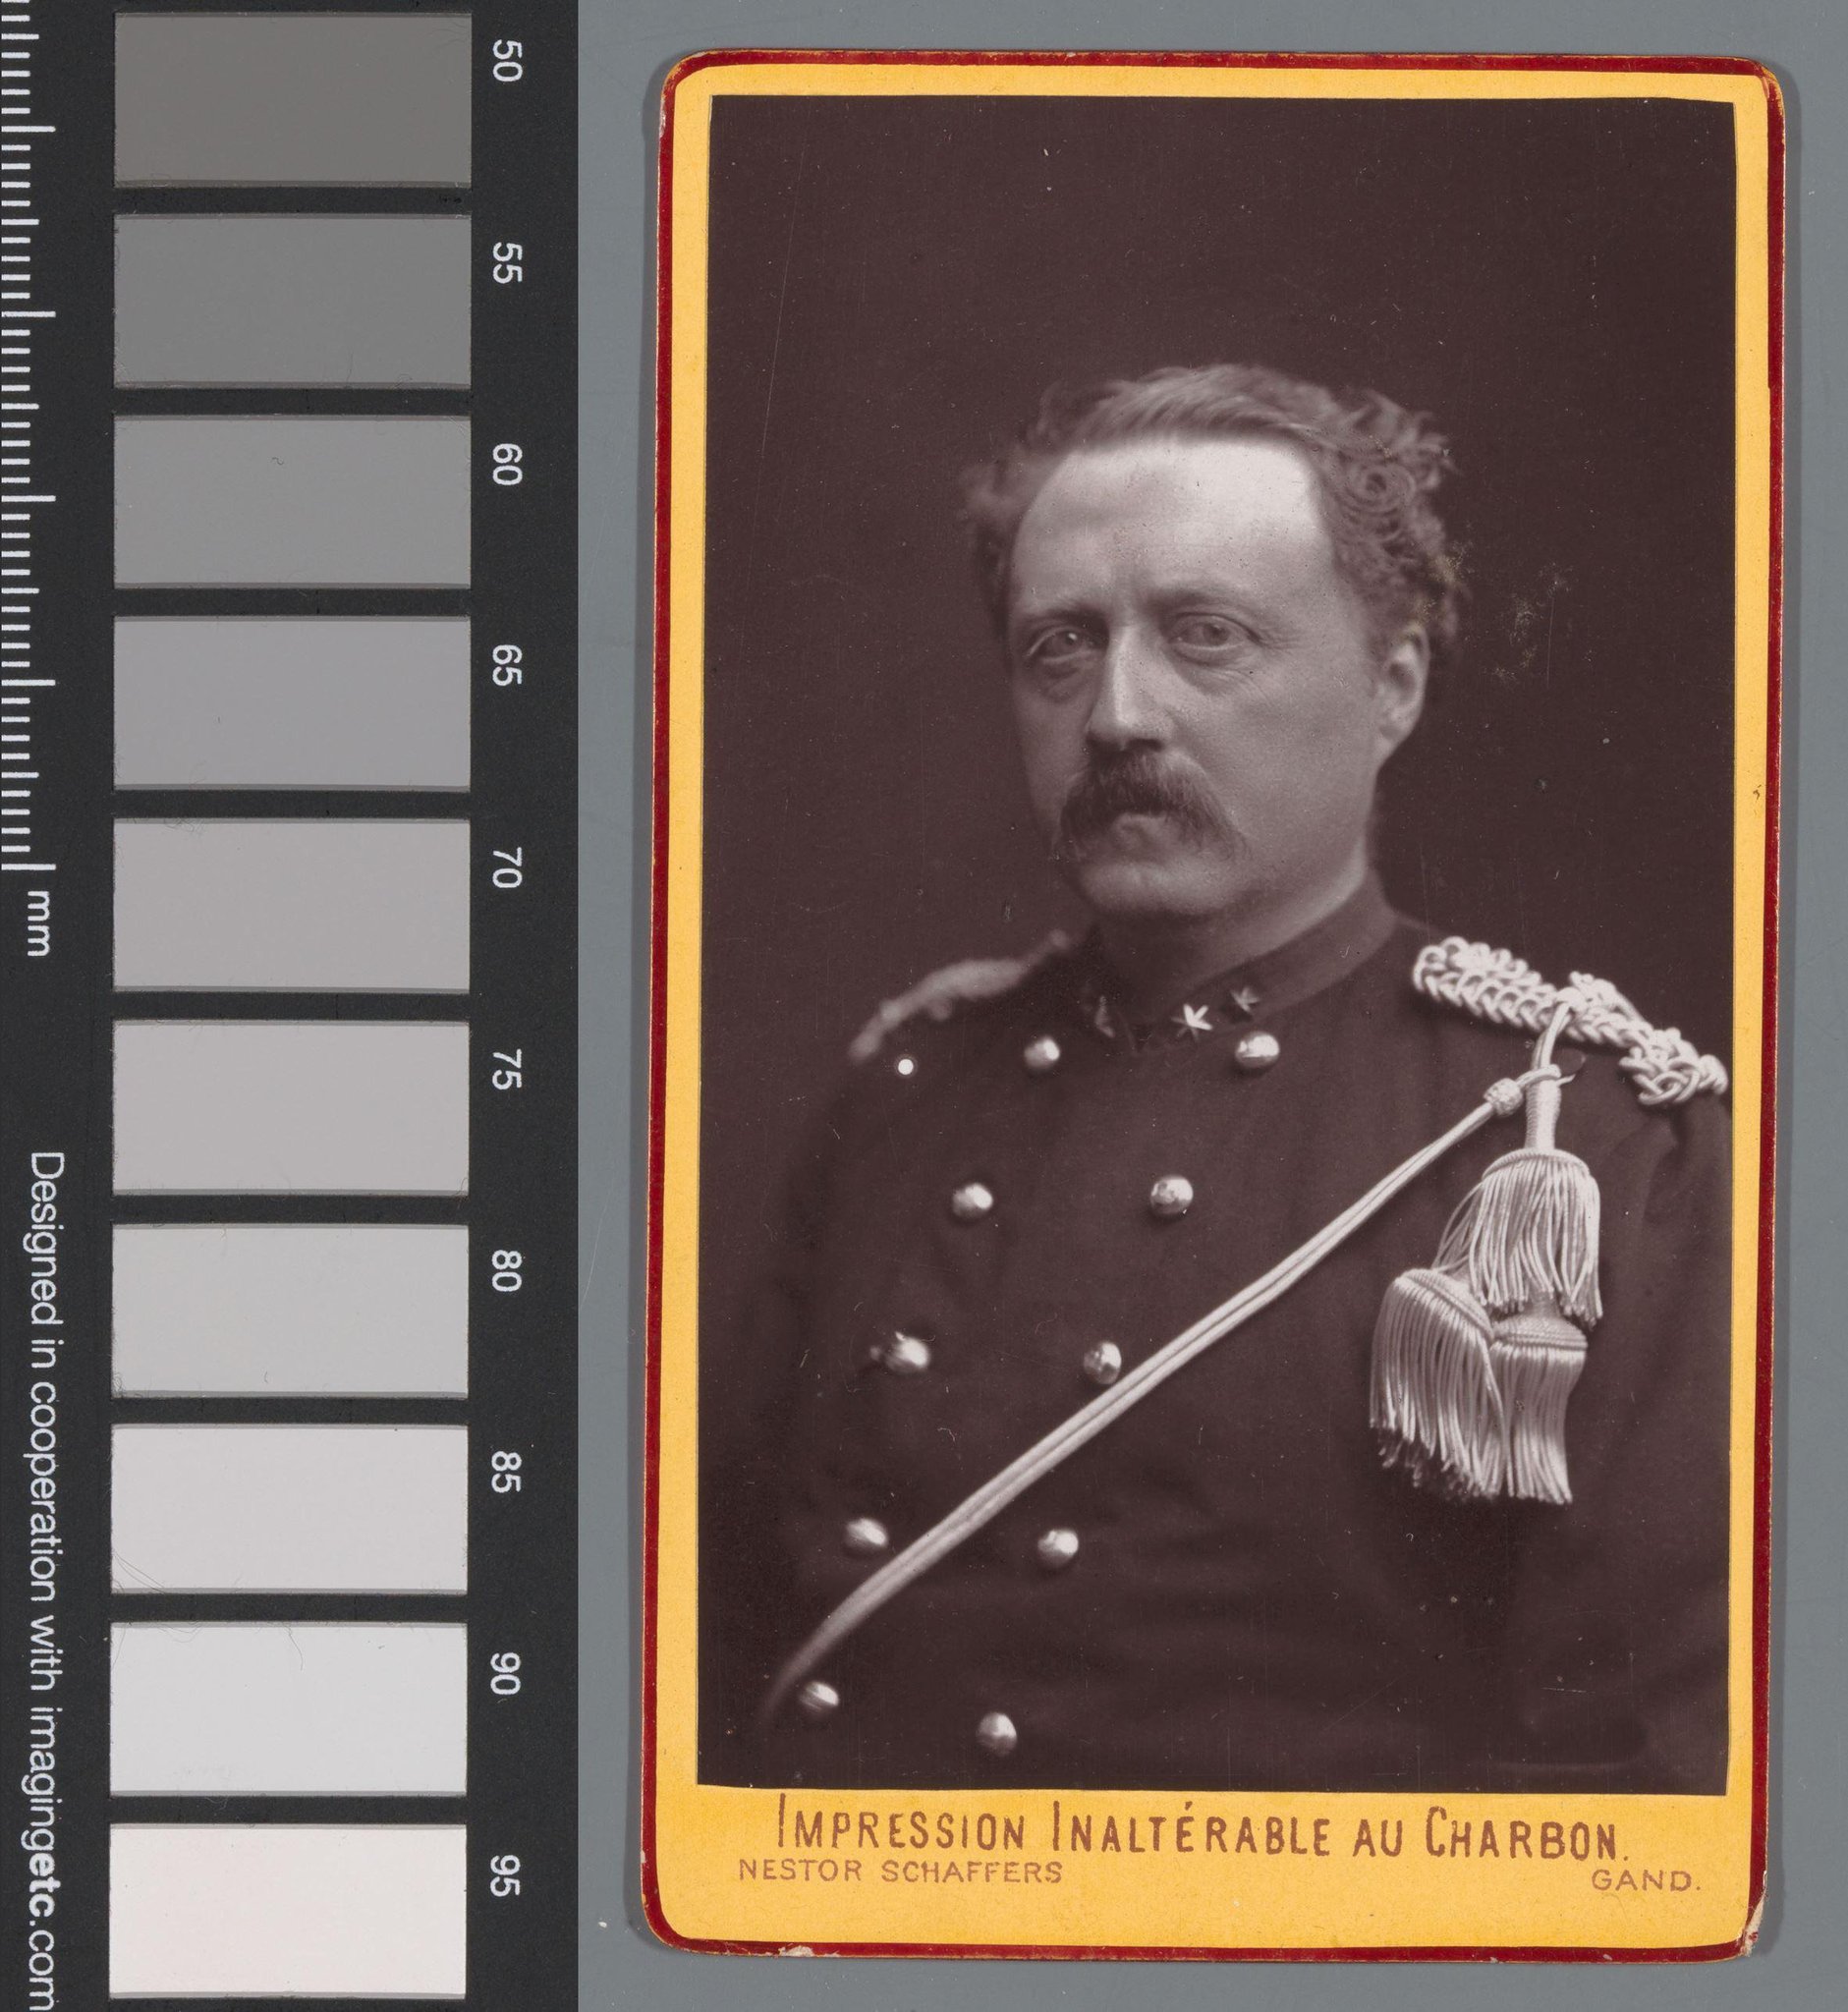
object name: photograph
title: Portret van een onbekende man in uniform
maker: paul joseph nicolas nestor schaffers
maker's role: fotograaf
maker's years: 1826-1896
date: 1875-1896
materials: cardboard, paper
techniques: carbon print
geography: ghent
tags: clothes for official occasions, adult man, anonymous historical person portrayed, ghent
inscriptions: monogram: ‘NS’, inscription: ‘Impression Inaltérable au Charbon./ Nestor Schaffers Gand.’, inscription: ‘Nestor Schaffers/ photographe/ rue Guinard/ Gand.’